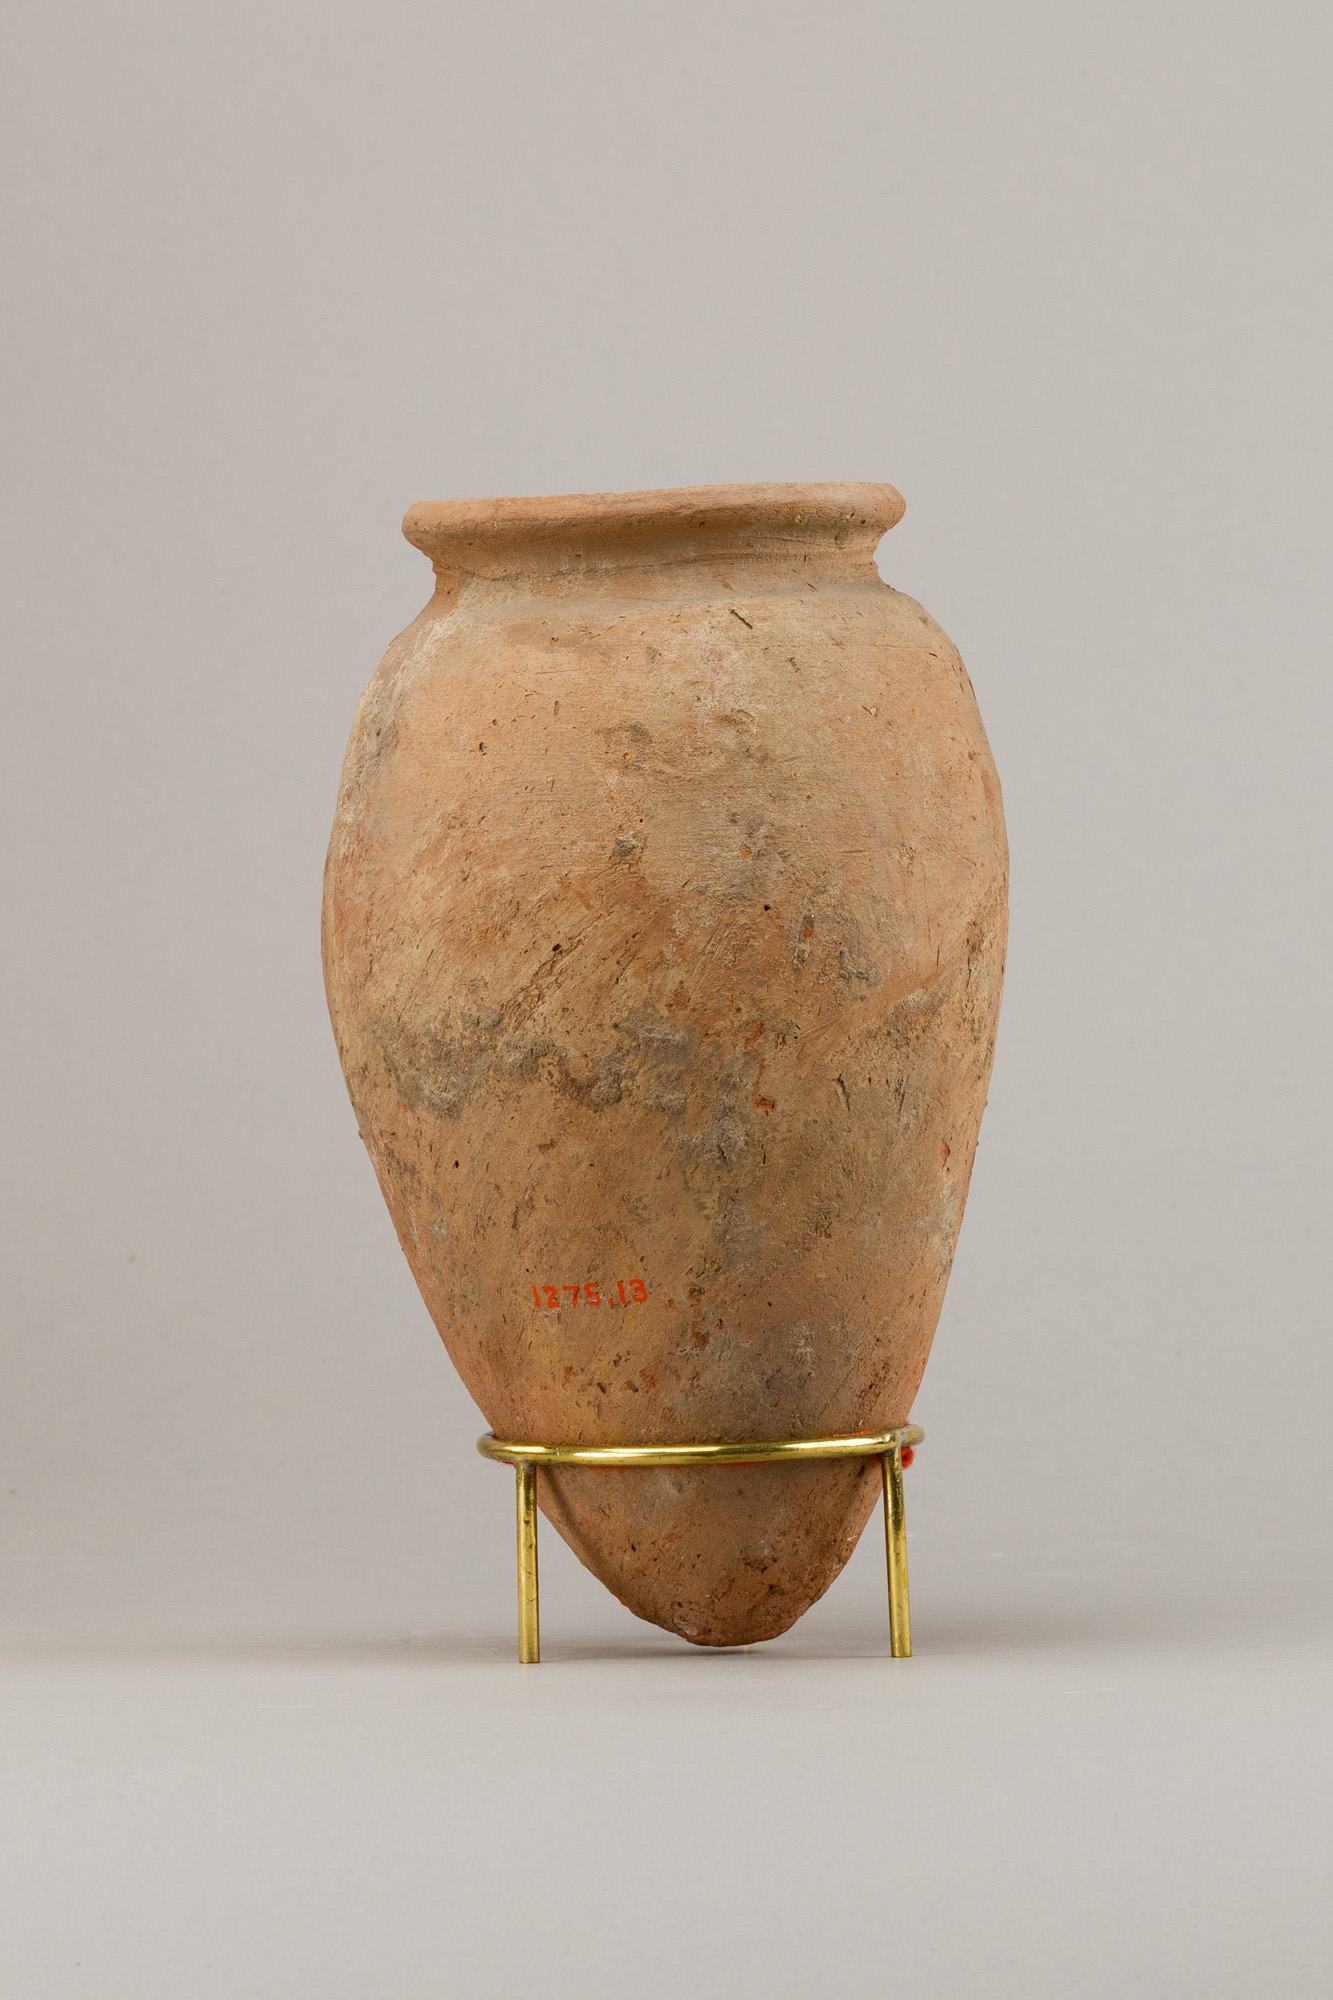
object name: jar, rough ware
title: Rough ware jar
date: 2960-2770 BCE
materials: pottery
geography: egypt